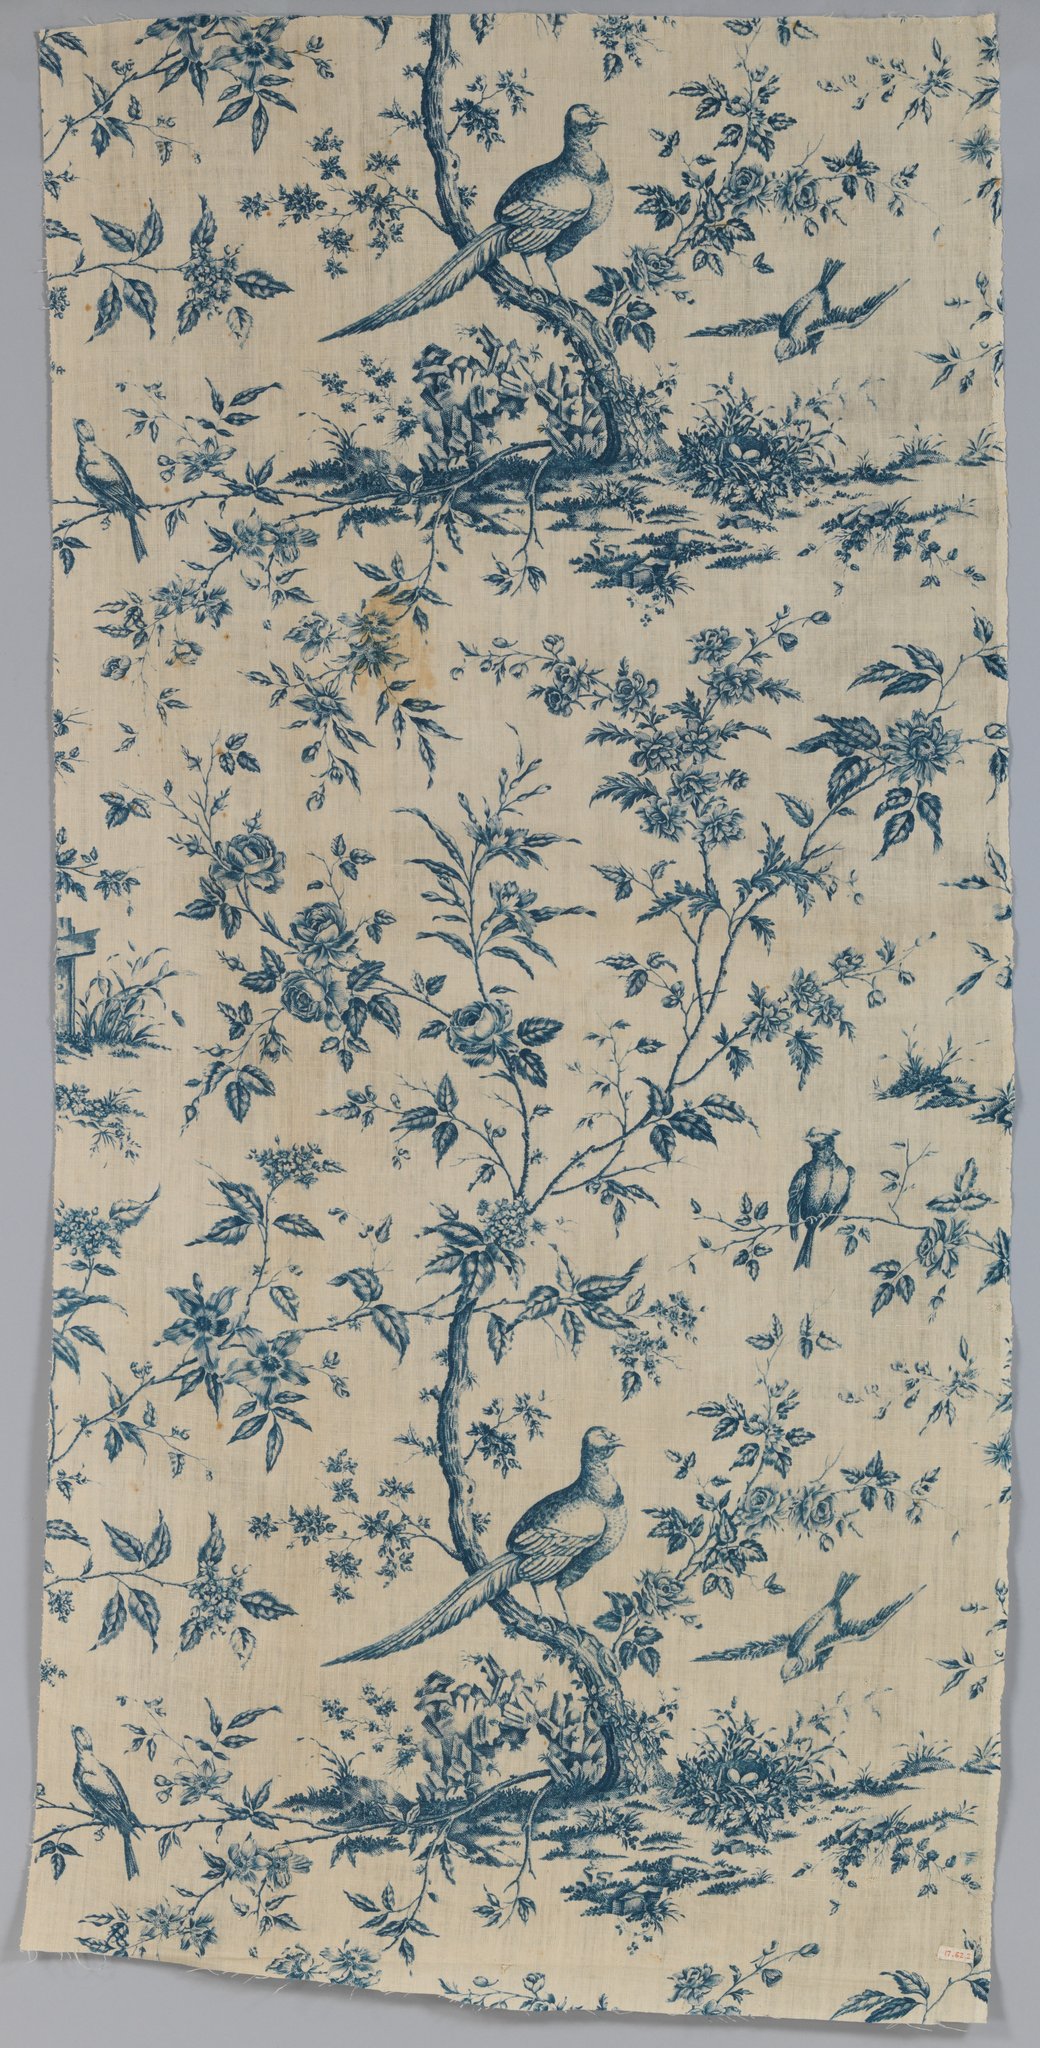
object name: piece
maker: bromley hall printworks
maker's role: manufactory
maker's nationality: english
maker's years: 1694-1823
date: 1780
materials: linen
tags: birds,flowers,leaves,trees